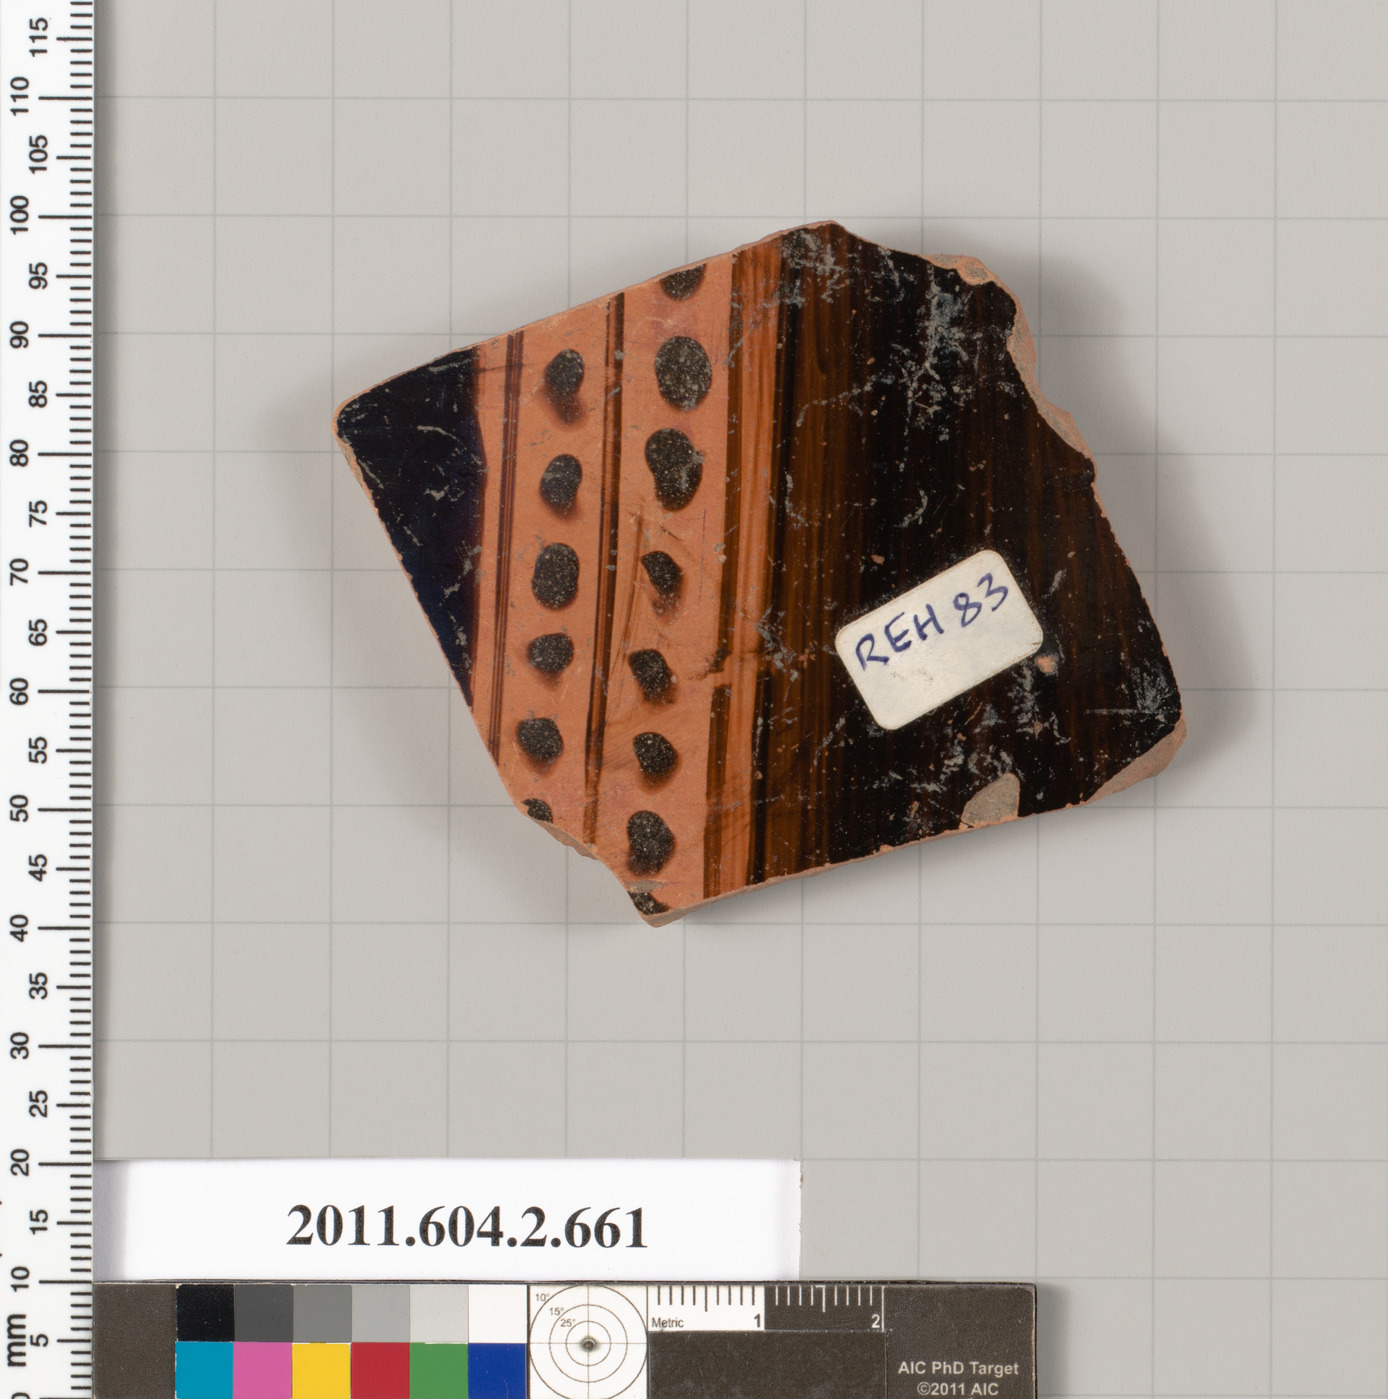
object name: column krater fragment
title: Terracotta fragment of a column-krater (bowl for mixing wine and water)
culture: greek, attic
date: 460-440 BCE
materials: terracotta